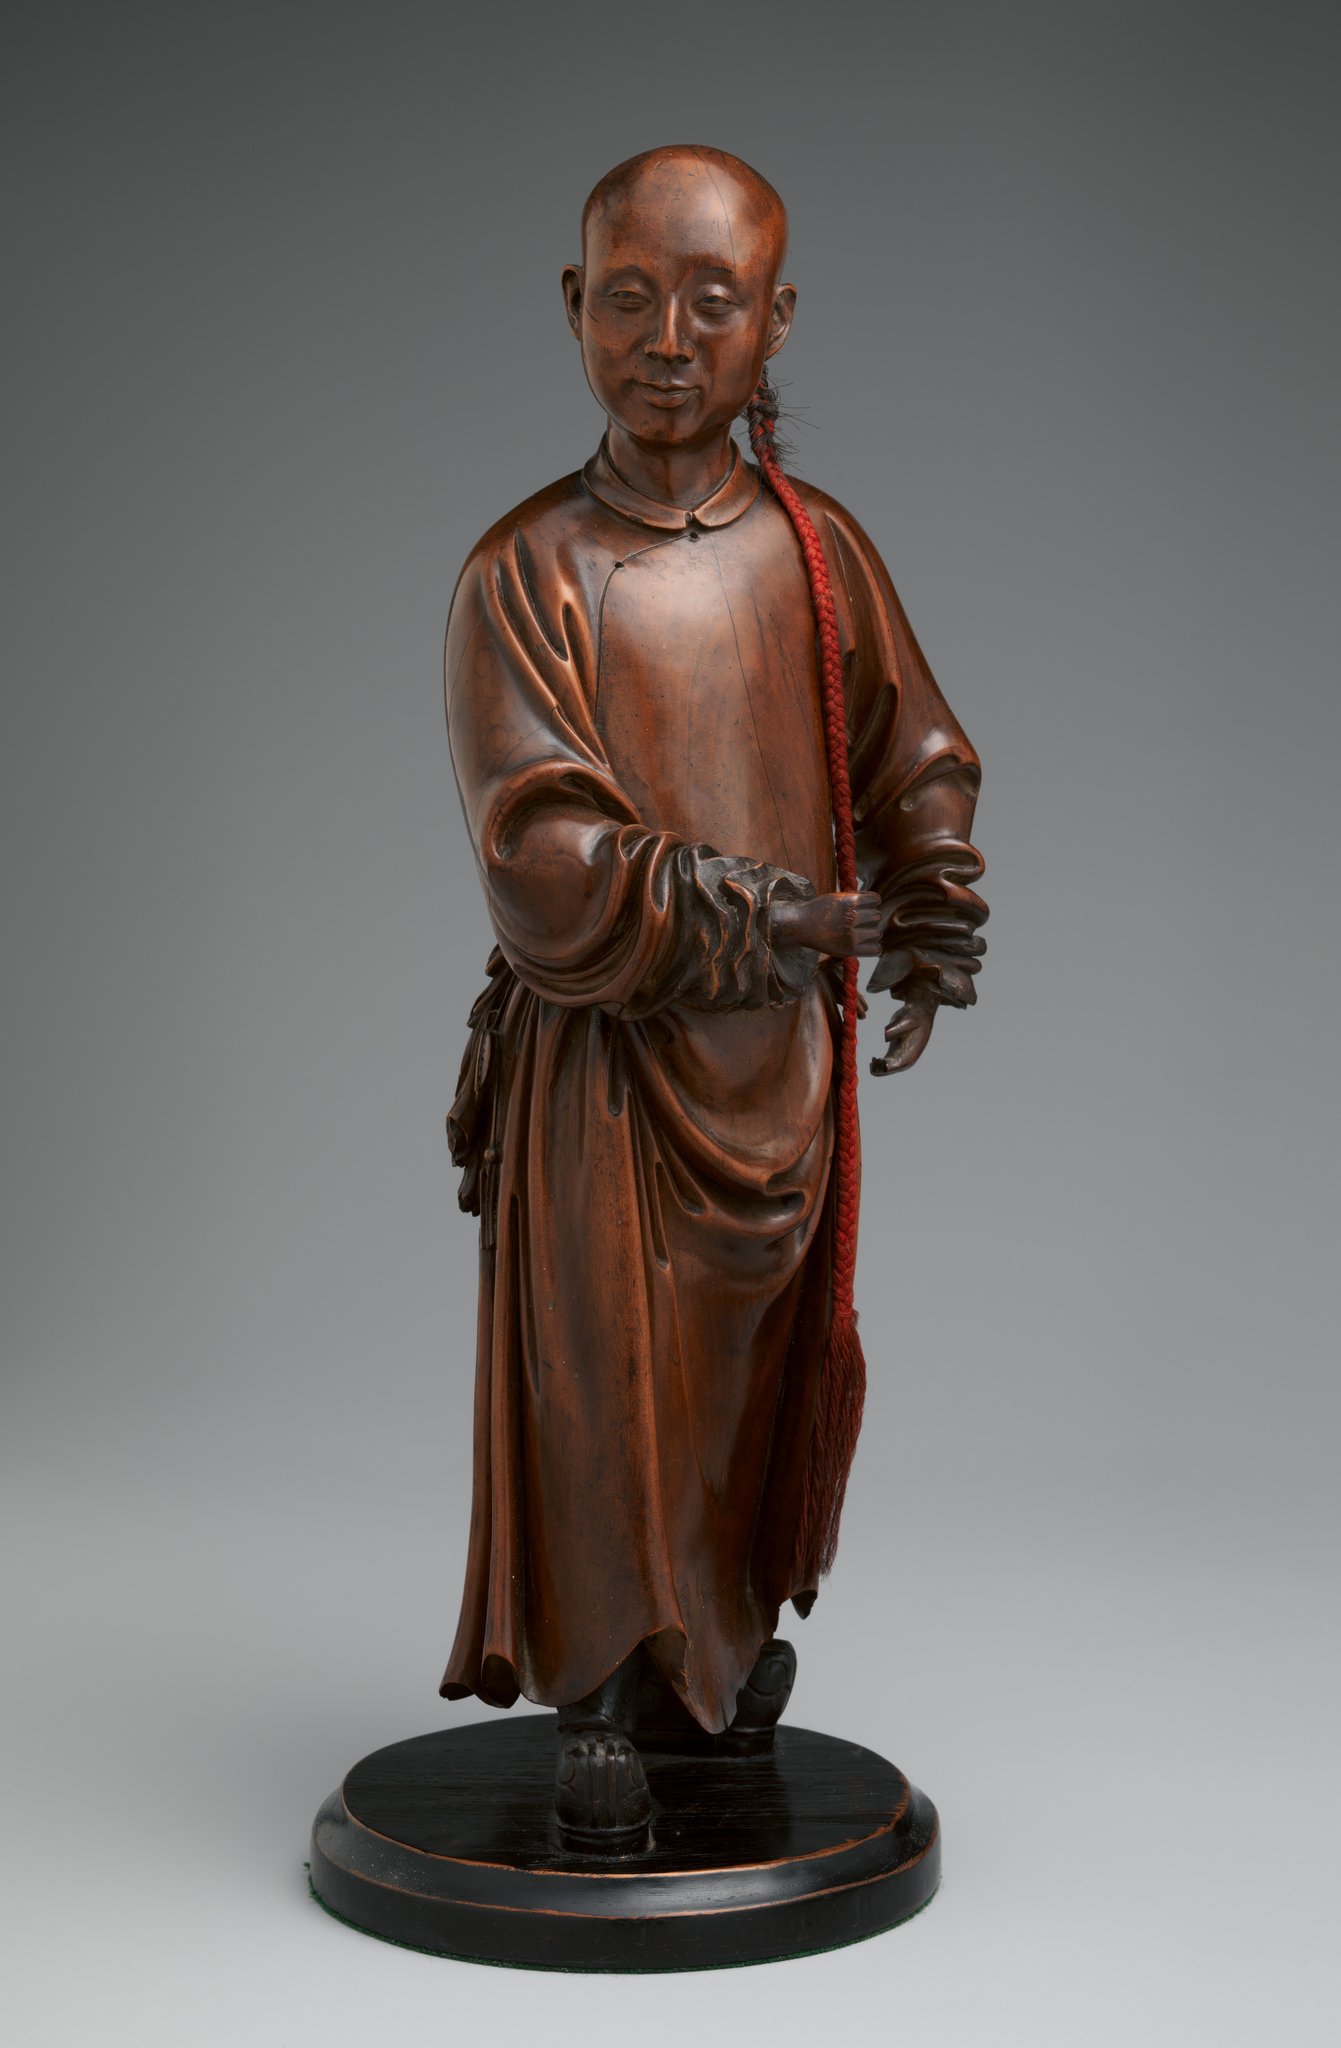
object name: figure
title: Figure of a gentleman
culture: chinese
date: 1701-1900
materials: wood, hair, silk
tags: men